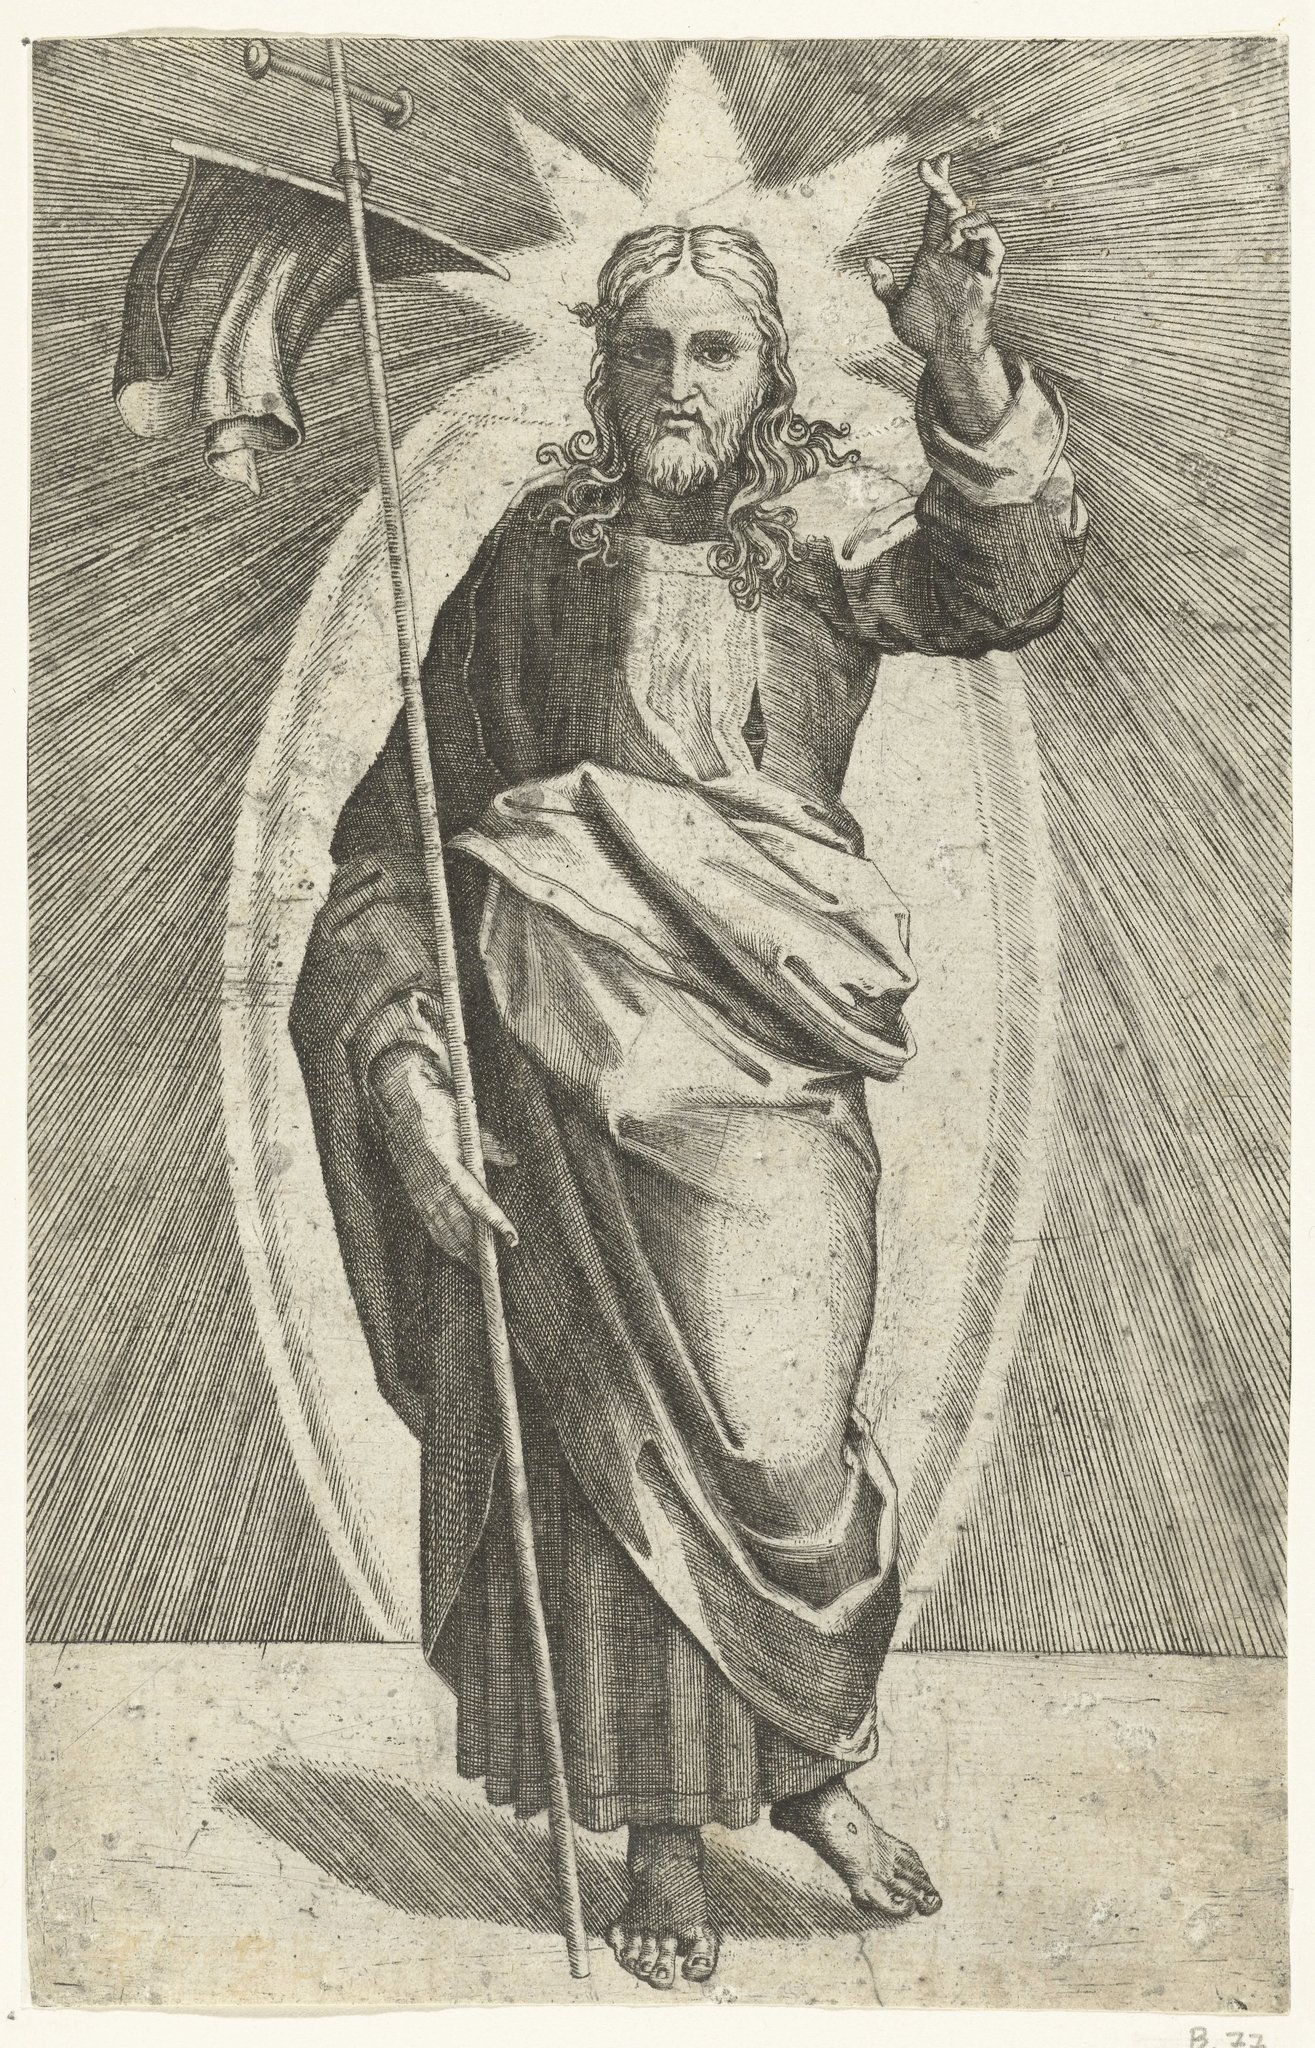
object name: print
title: Christus en de Apostelen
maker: marcantonio raimondi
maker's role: print maker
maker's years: 1470-1534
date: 1517-1527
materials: paper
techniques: engraving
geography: italy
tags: 'salvator mundi', making a blessing gesture; an orb in his hand or at his feet